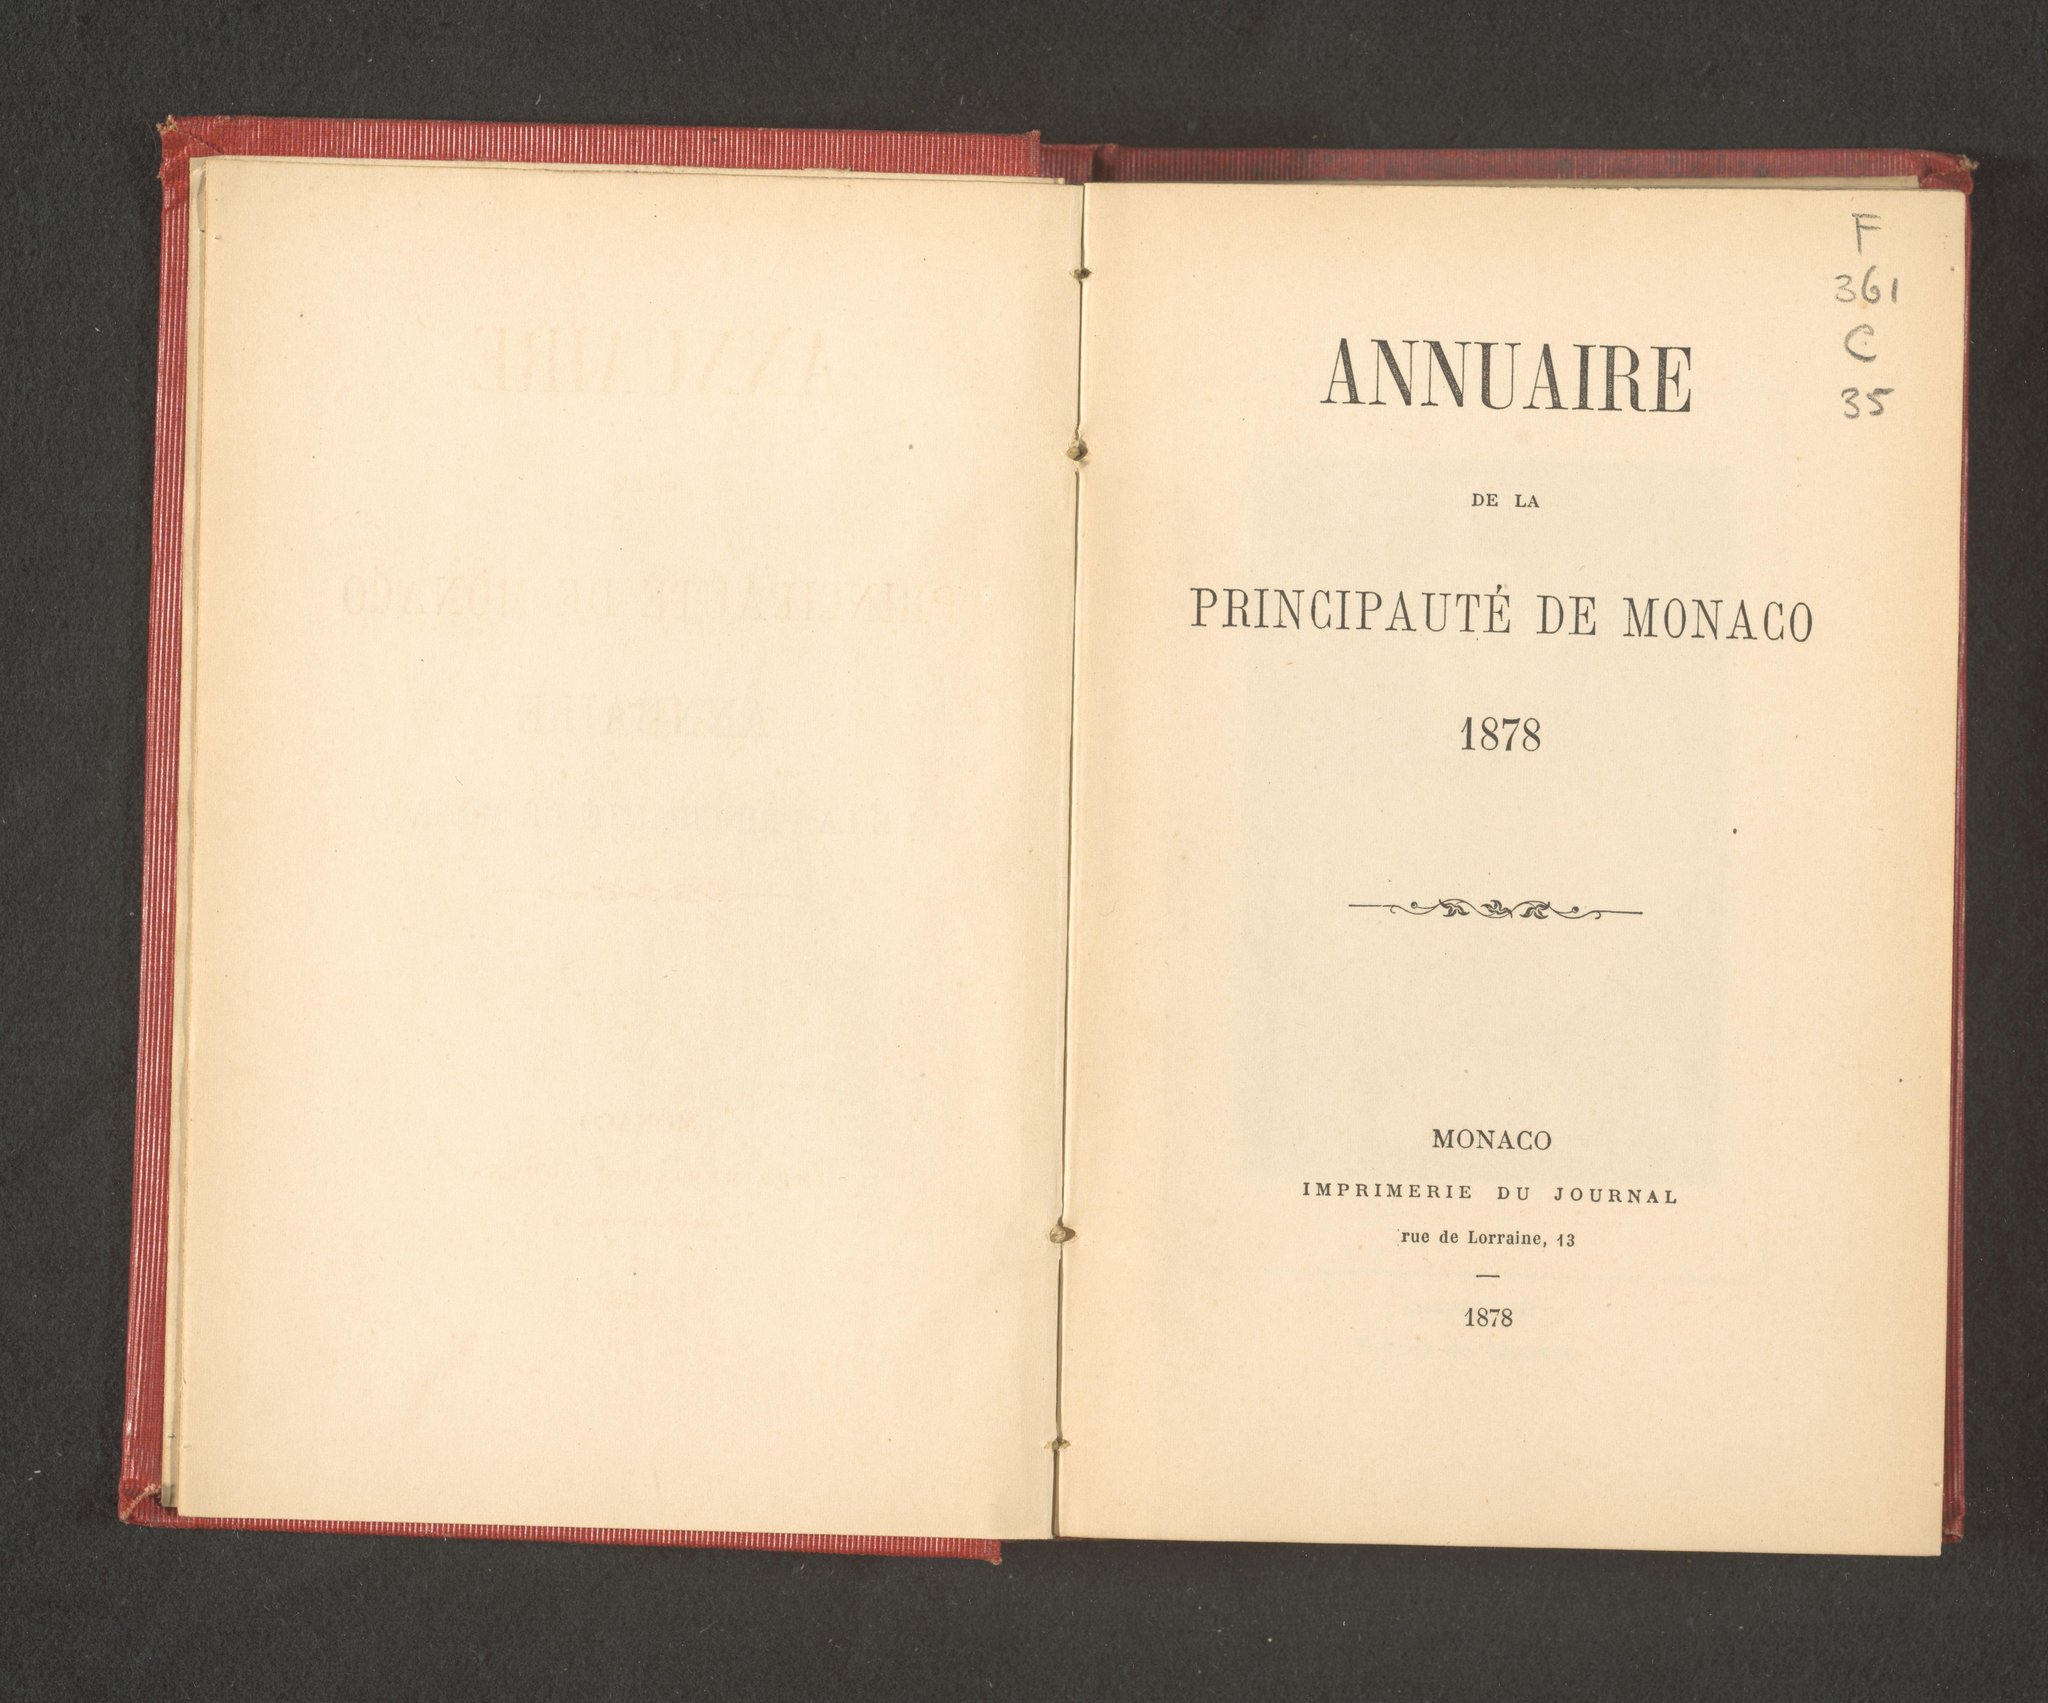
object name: book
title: Annuaire de la Principauté de Monaco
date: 1878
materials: cardboard, paper, photographic support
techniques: albumen print, printing, engraving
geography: monaco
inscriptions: date: ‘JULY/ 1984’